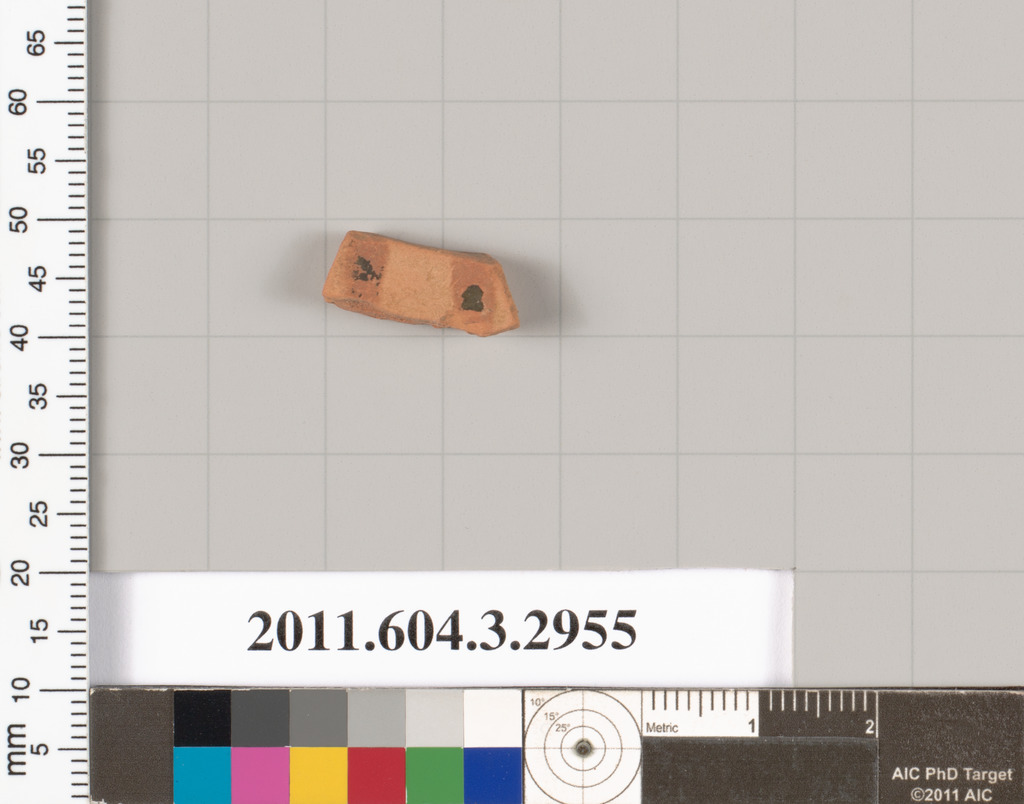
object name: undetermined closed shape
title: Terracotta fragment of a closed shape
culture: greek, attic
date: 600-401 BCE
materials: terracotta